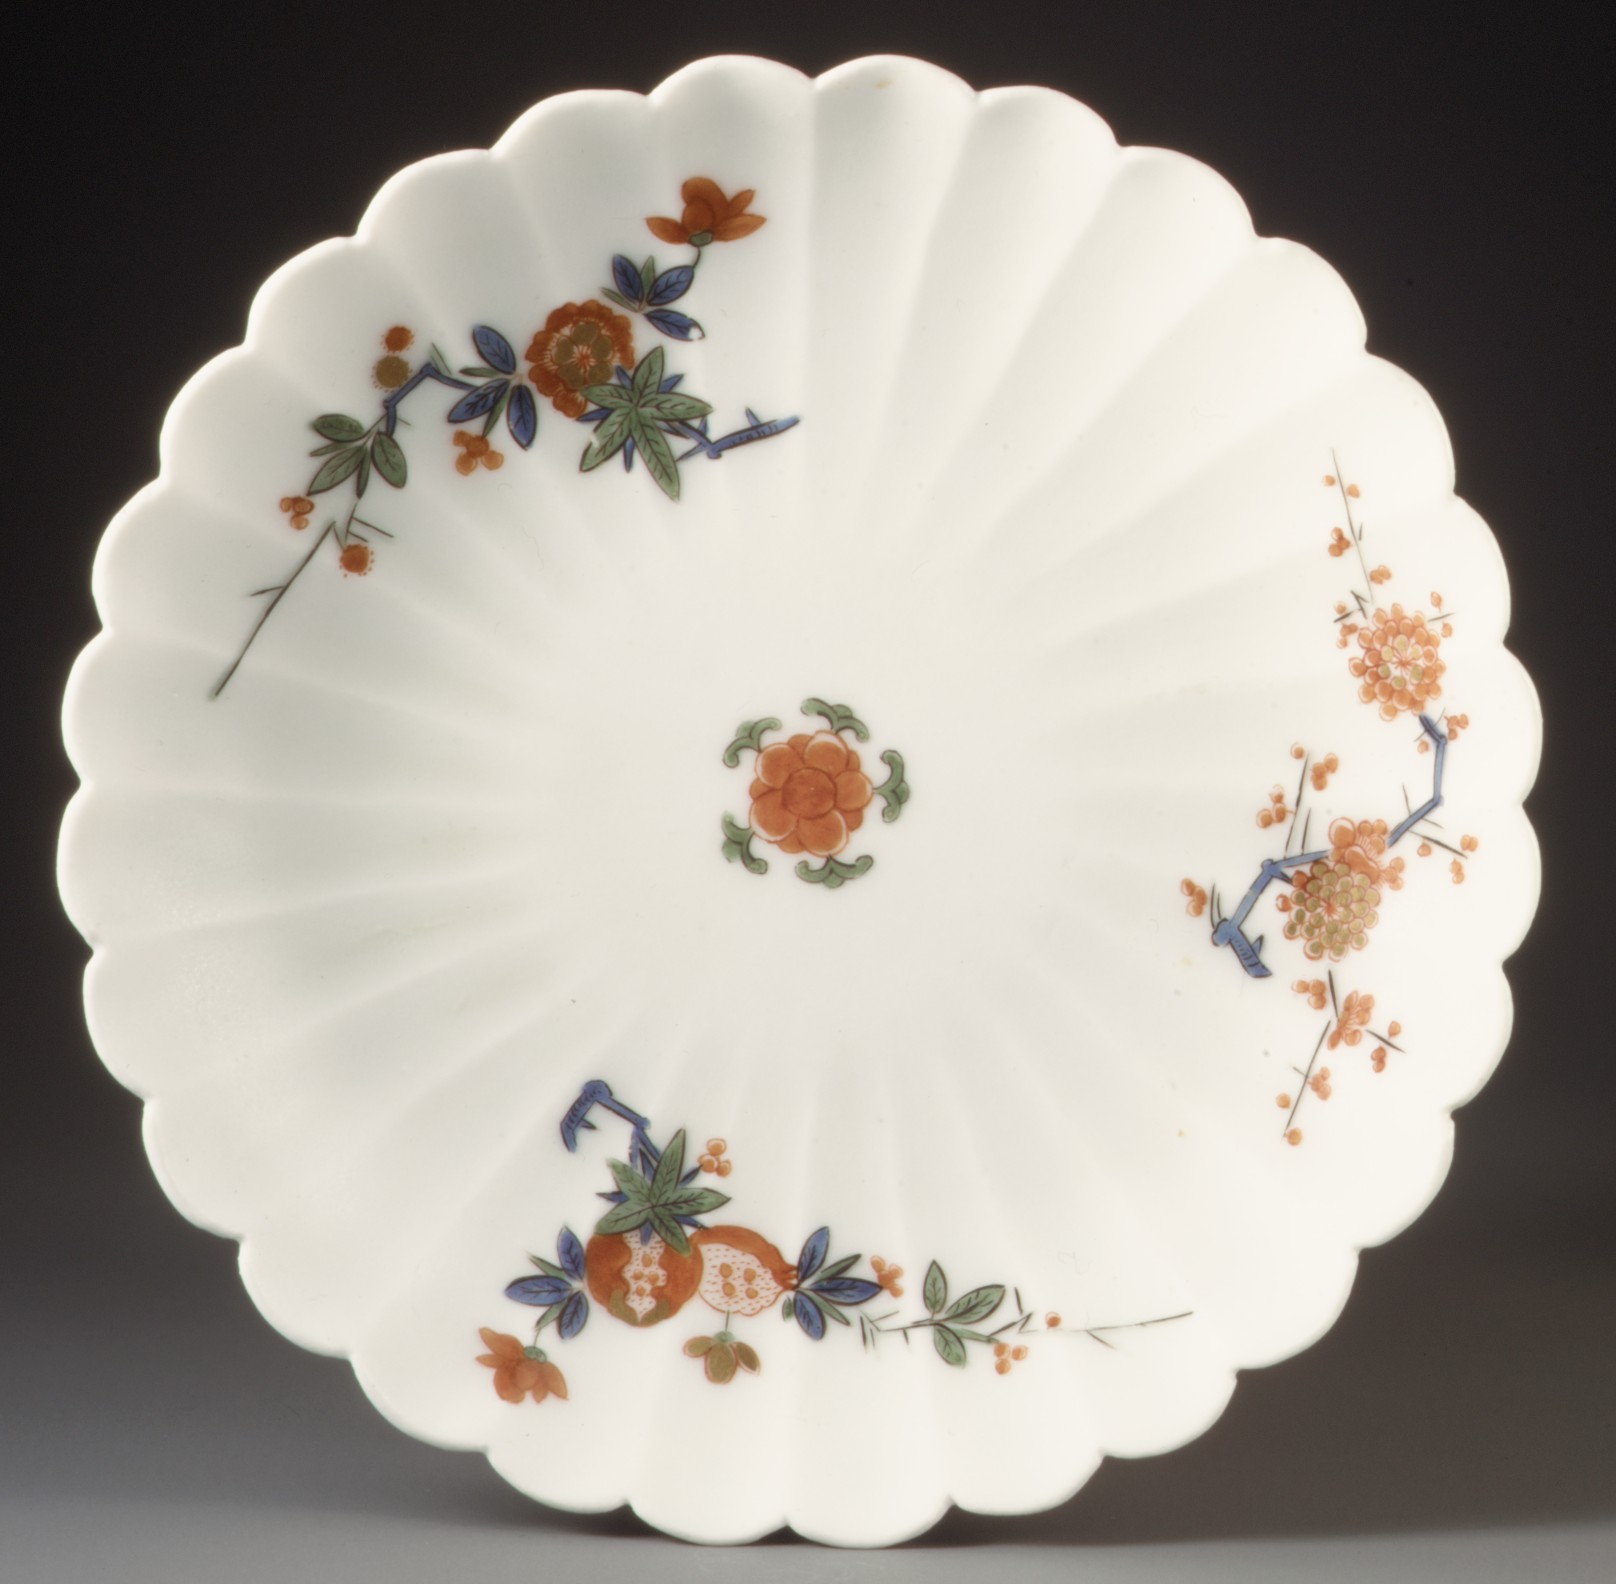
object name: saucer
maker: meissen manufactory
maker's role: manufactory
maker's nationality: german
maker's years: 1710-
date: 1730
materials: hard paste porcelain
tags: flowers